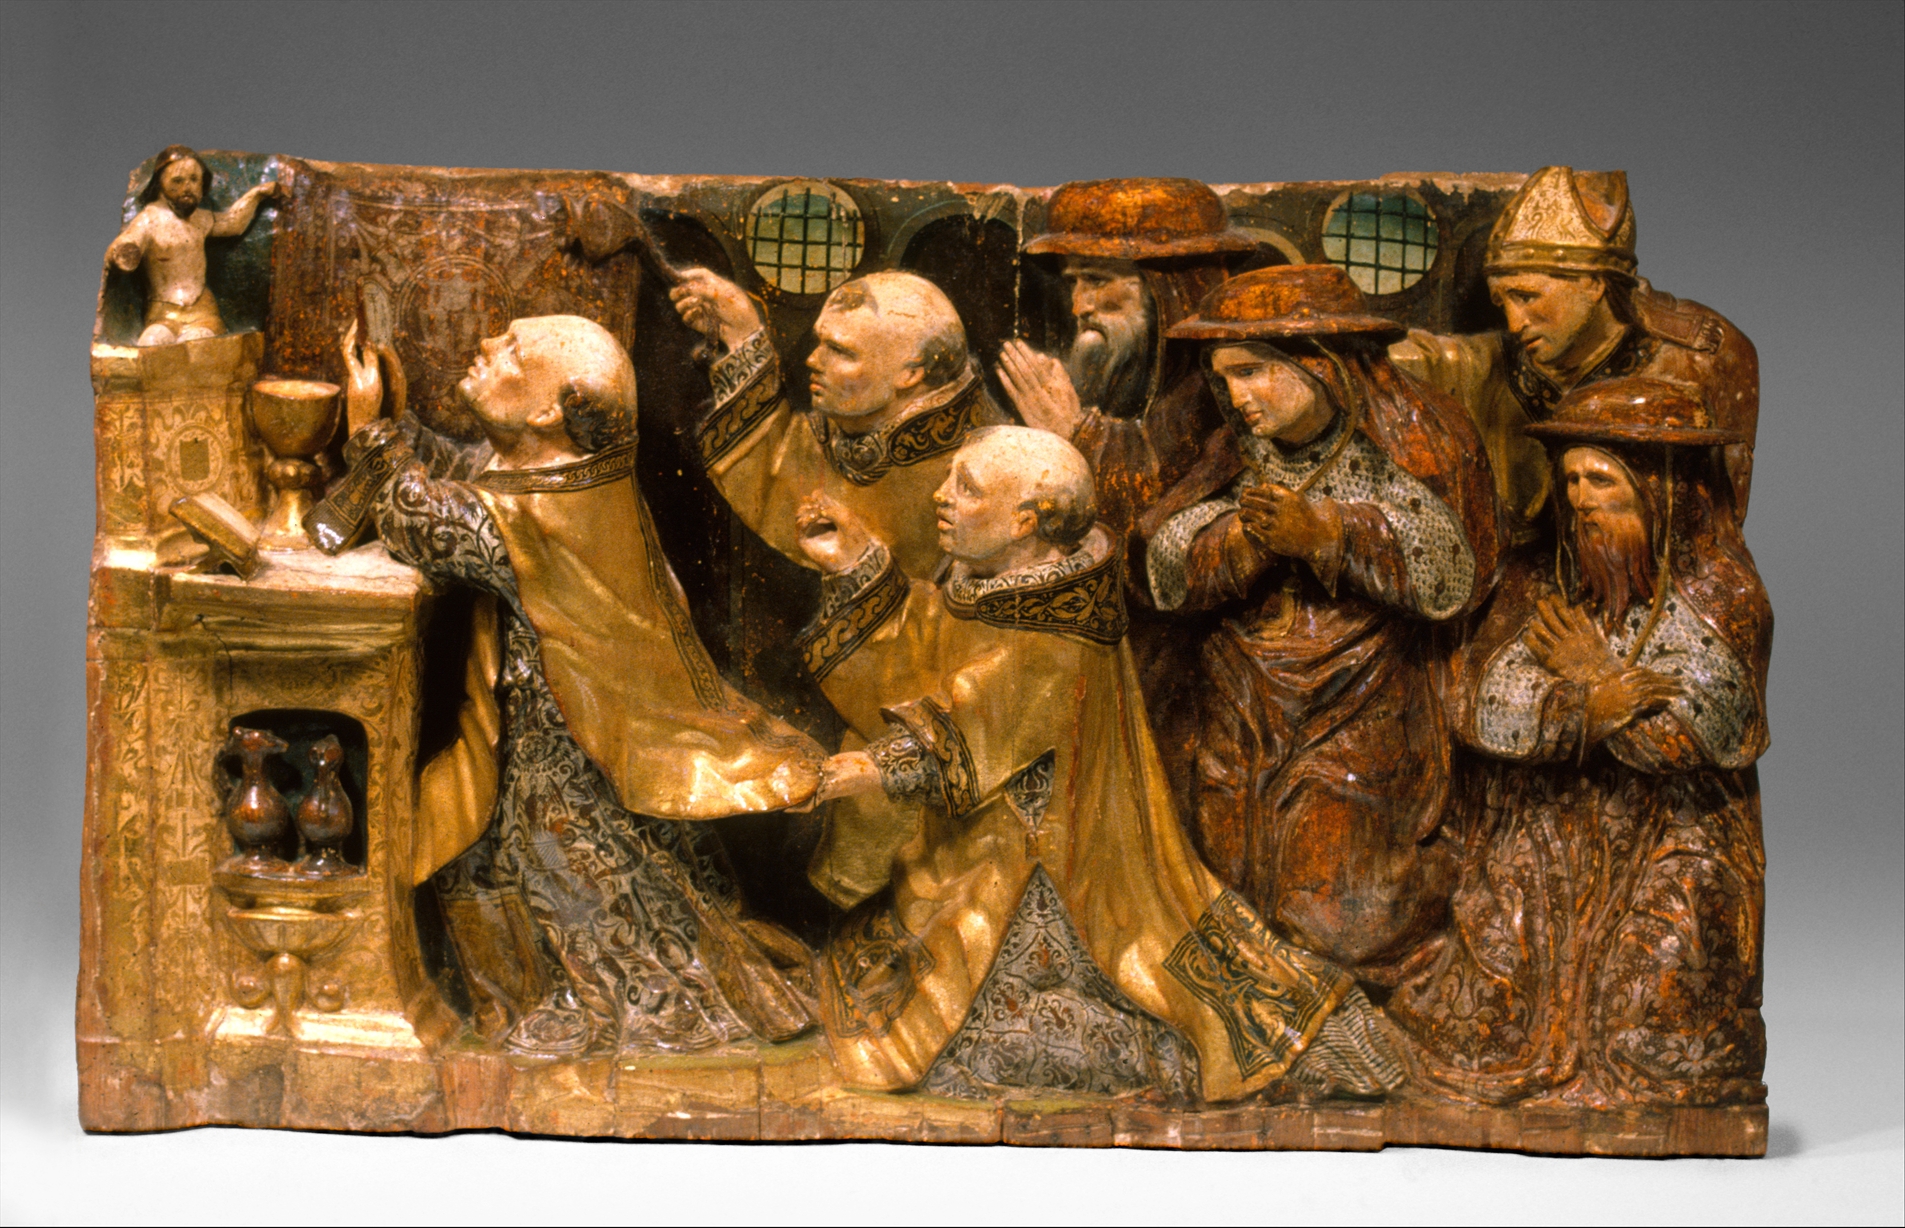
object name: relief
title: The Mass of St. Gregory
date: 1550-1560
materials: gilt, wood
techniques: polychrome, silvered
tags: altars,men,christ